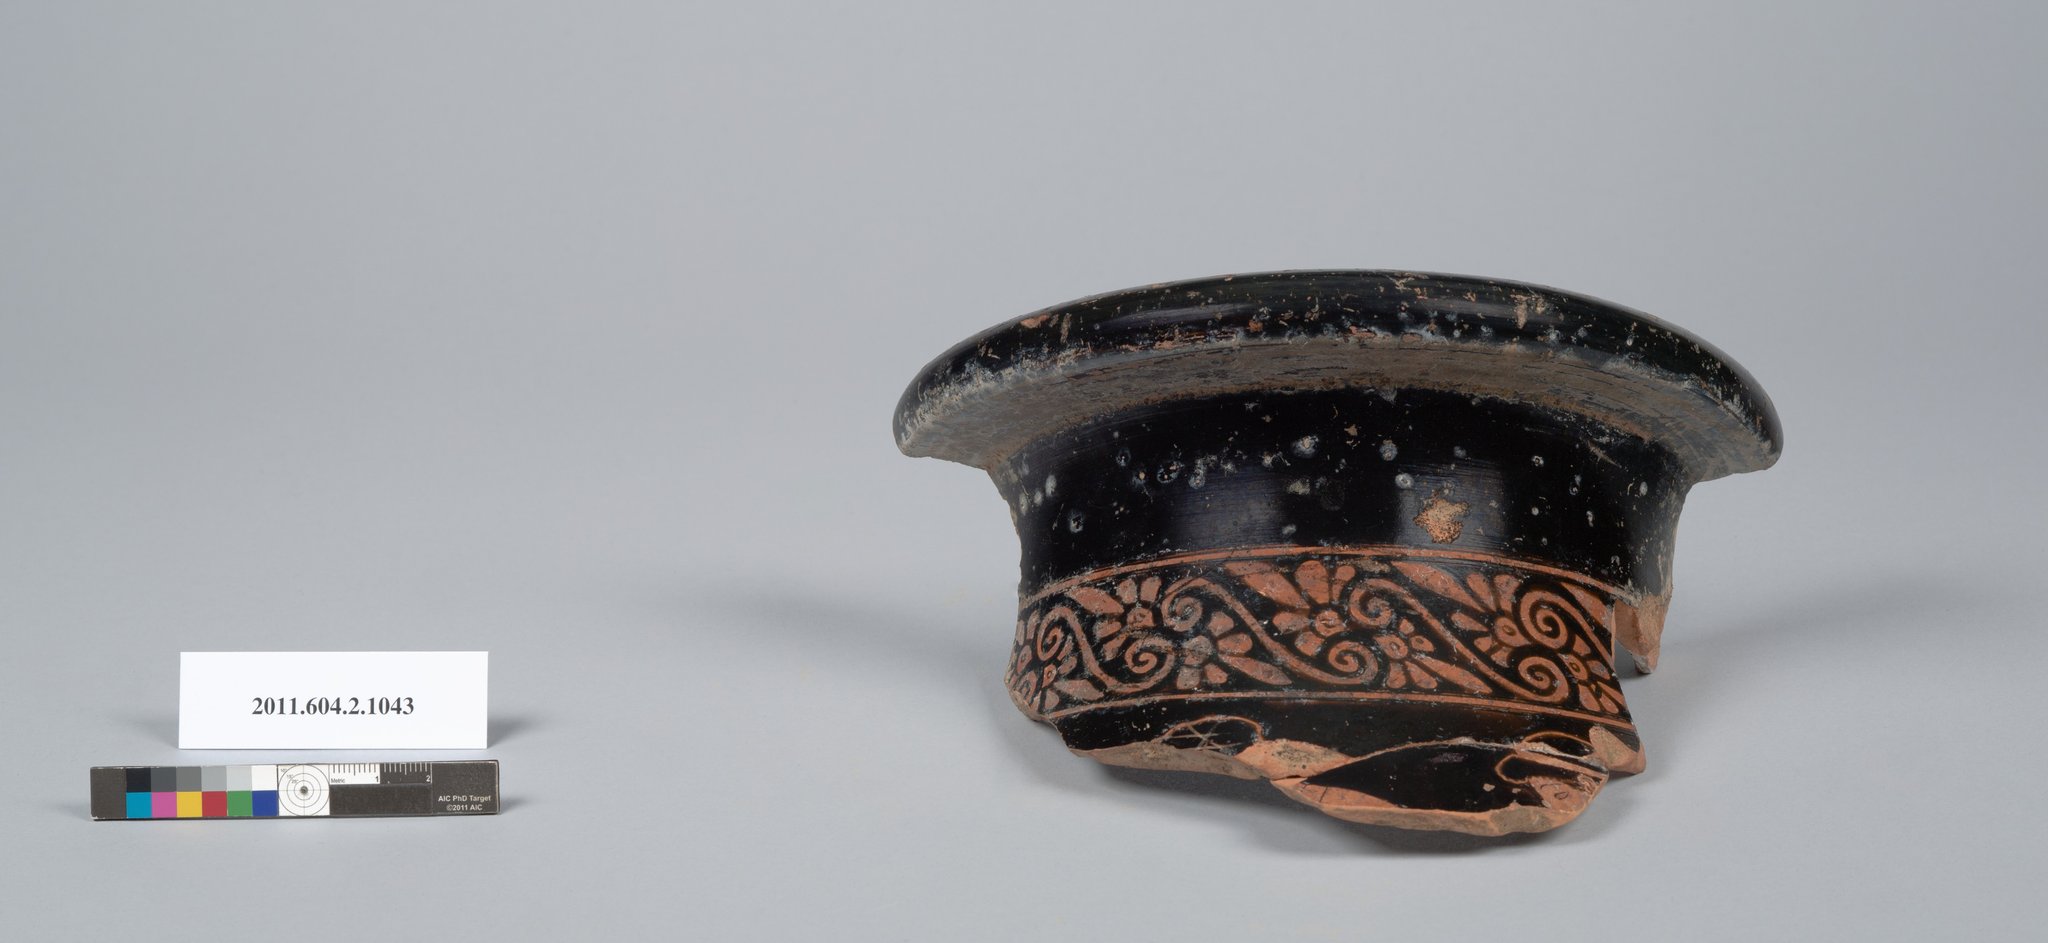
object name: pelike fragment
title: Terracotta fragment of a pelike (jar)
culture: greek, attic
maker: diogenes painter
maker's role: artist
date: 500-480 BCE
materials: terracotta